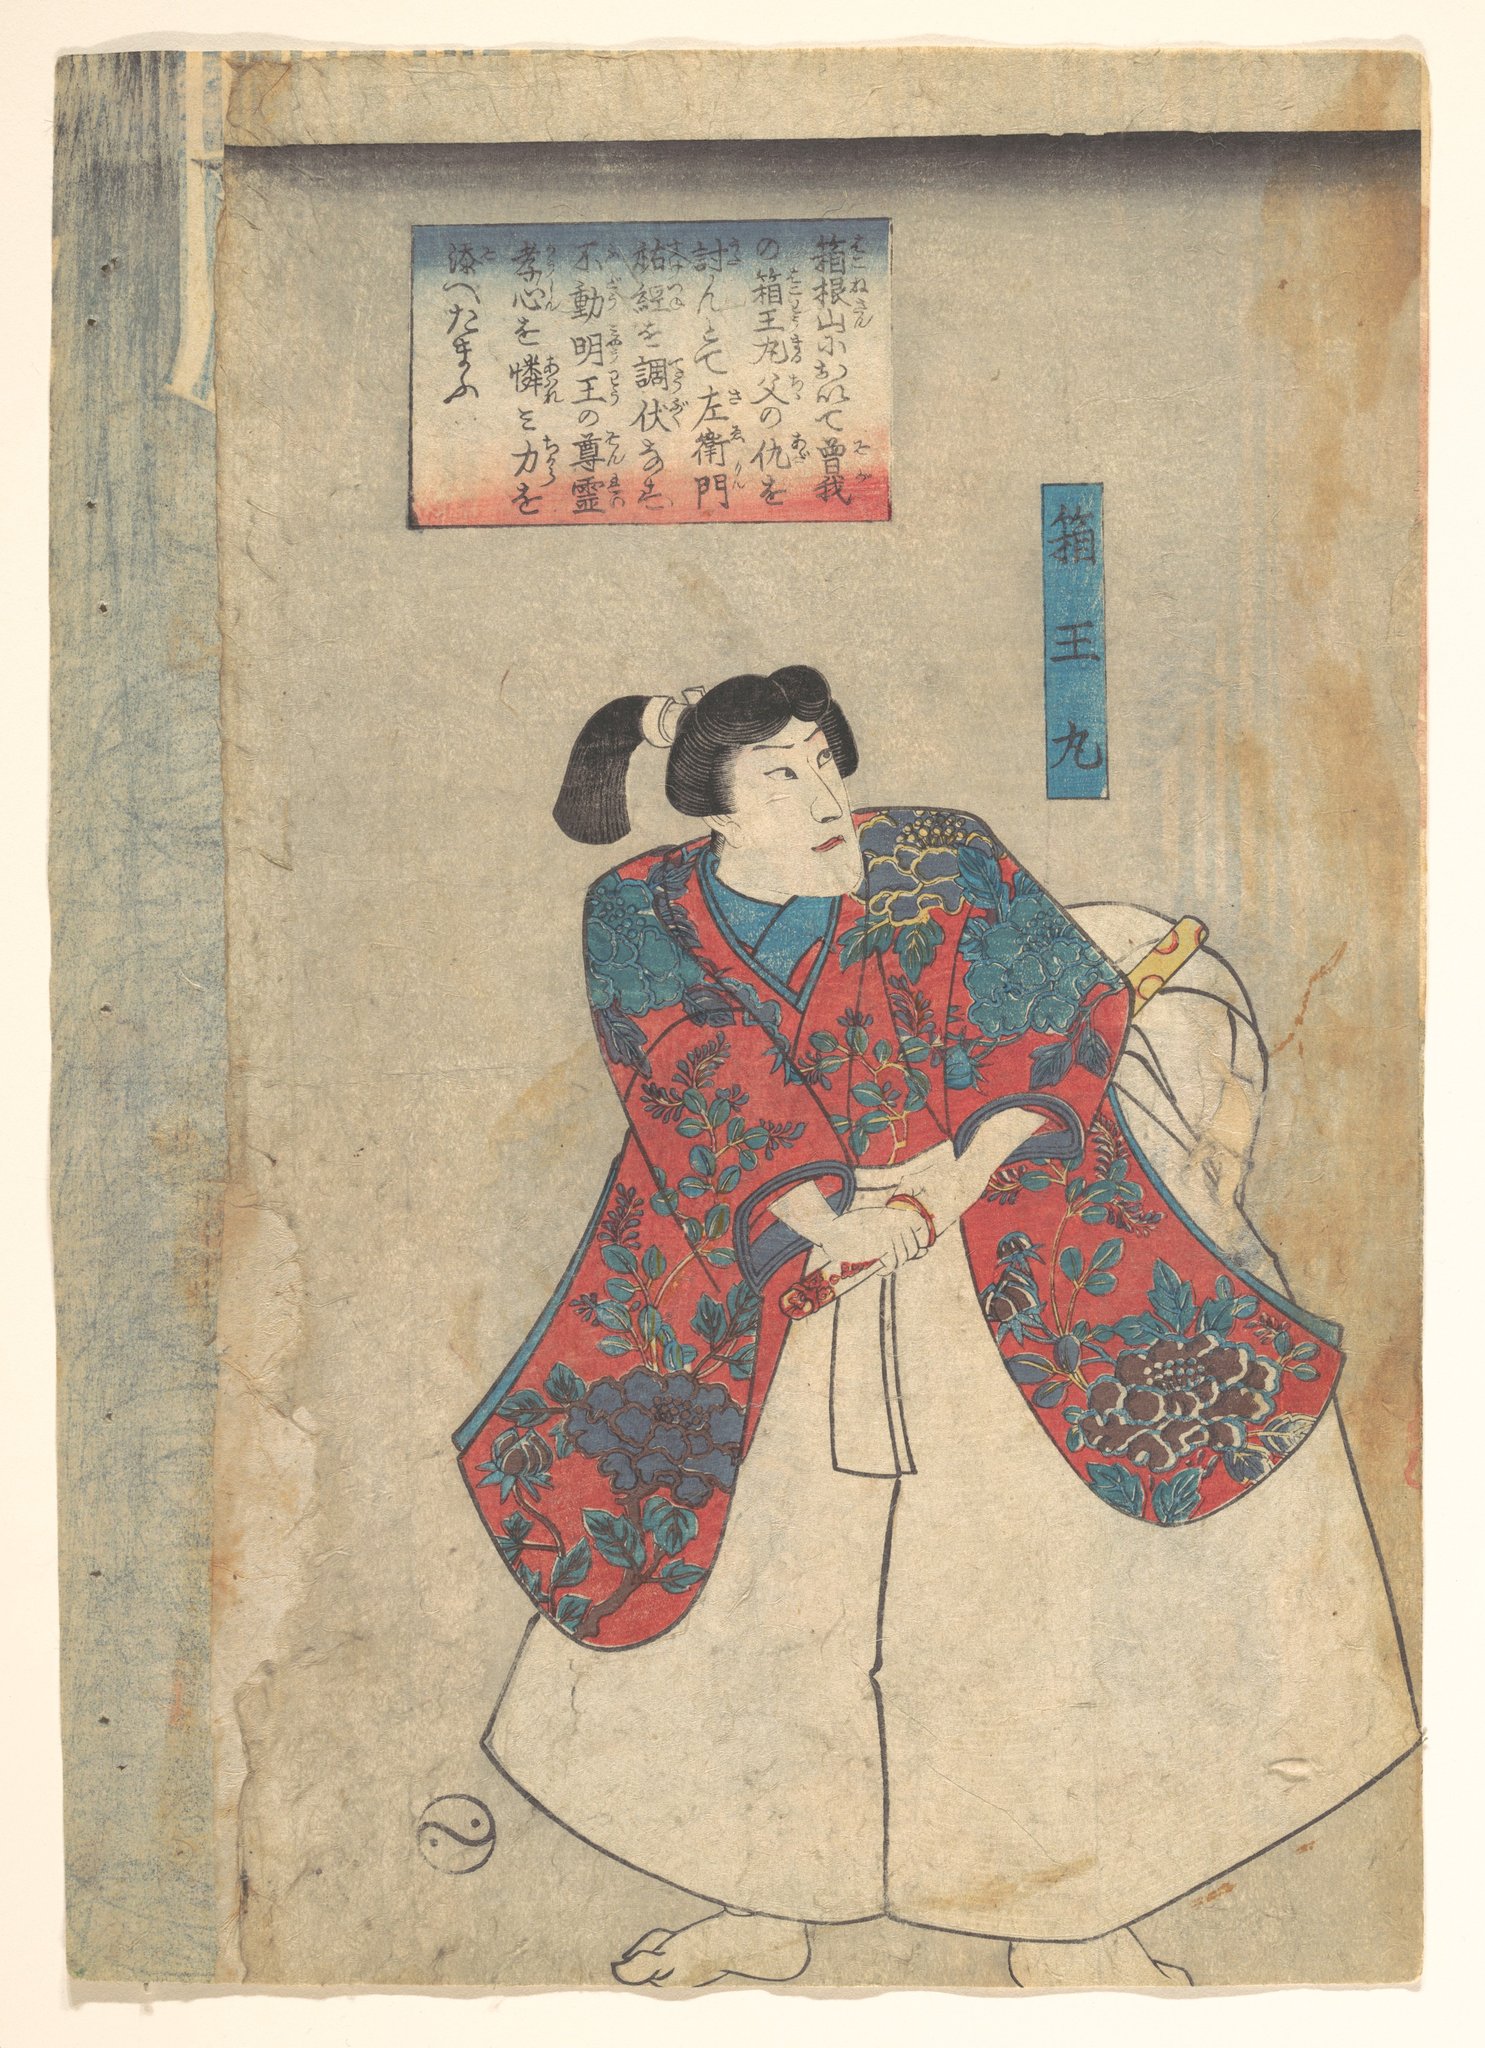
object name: print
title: Hakoōmaru, Buyū chikara-gusa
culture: japanese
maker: utagawa kuniyoshi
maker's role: artist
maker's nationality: japanese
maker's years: 1797-1861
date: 1801-1900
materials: ink, paper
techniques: woodblock print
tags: swords,women